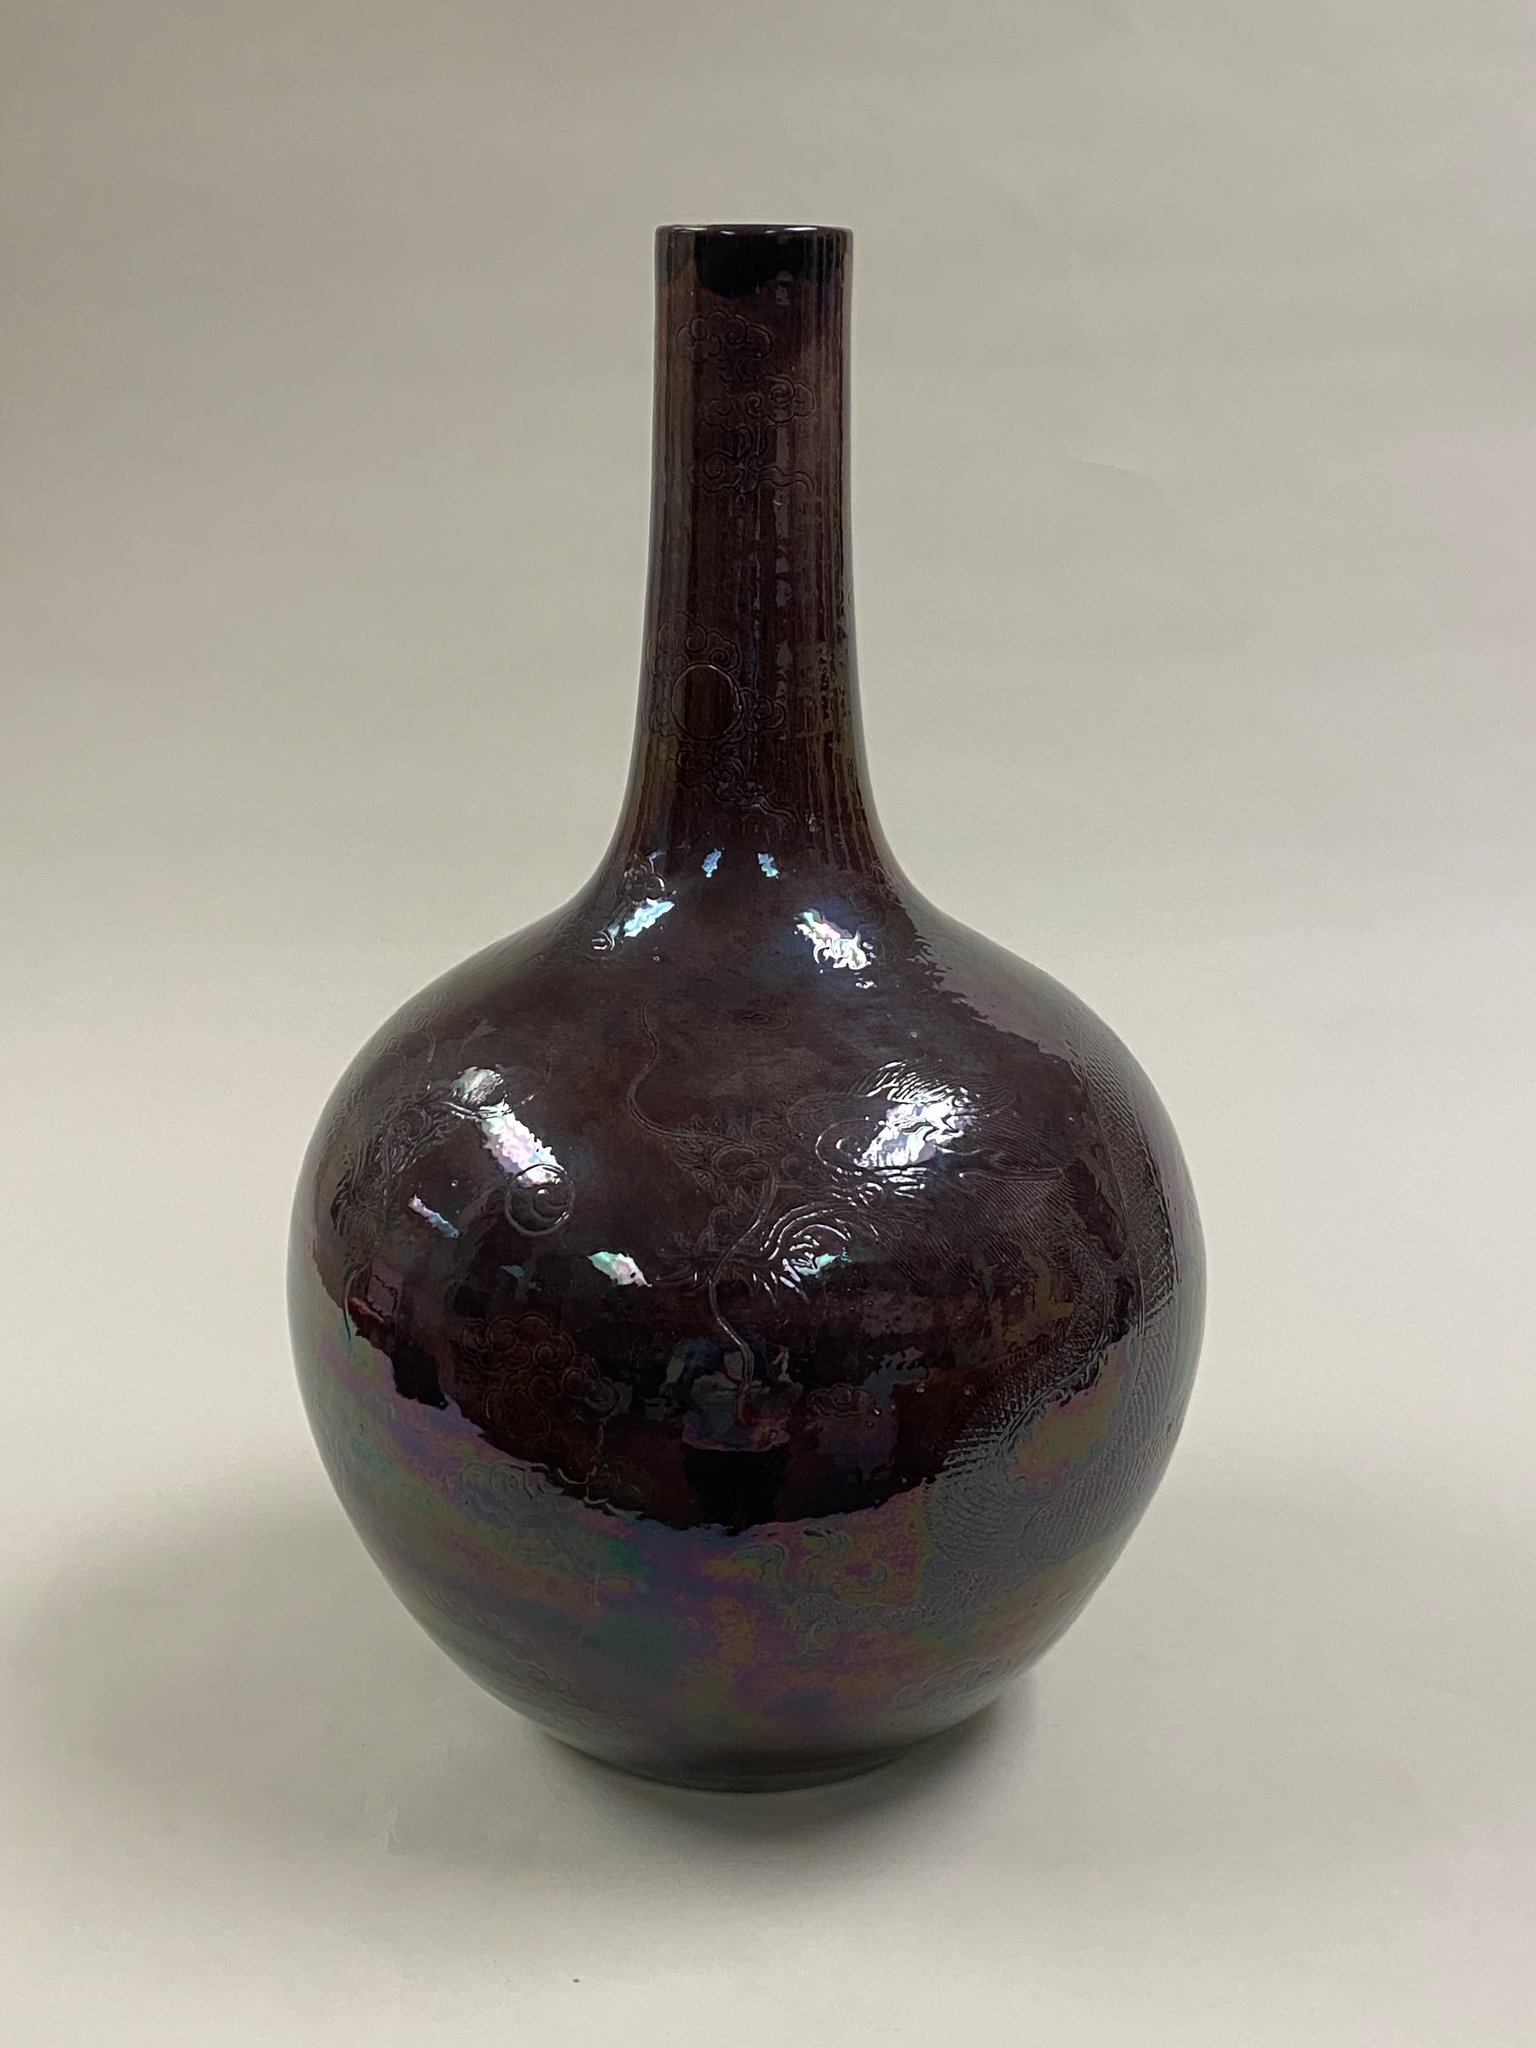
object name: bottle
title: Gobular bottle with dragon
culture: chinese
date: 1767-1800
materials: glaze, porcelain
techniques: incising